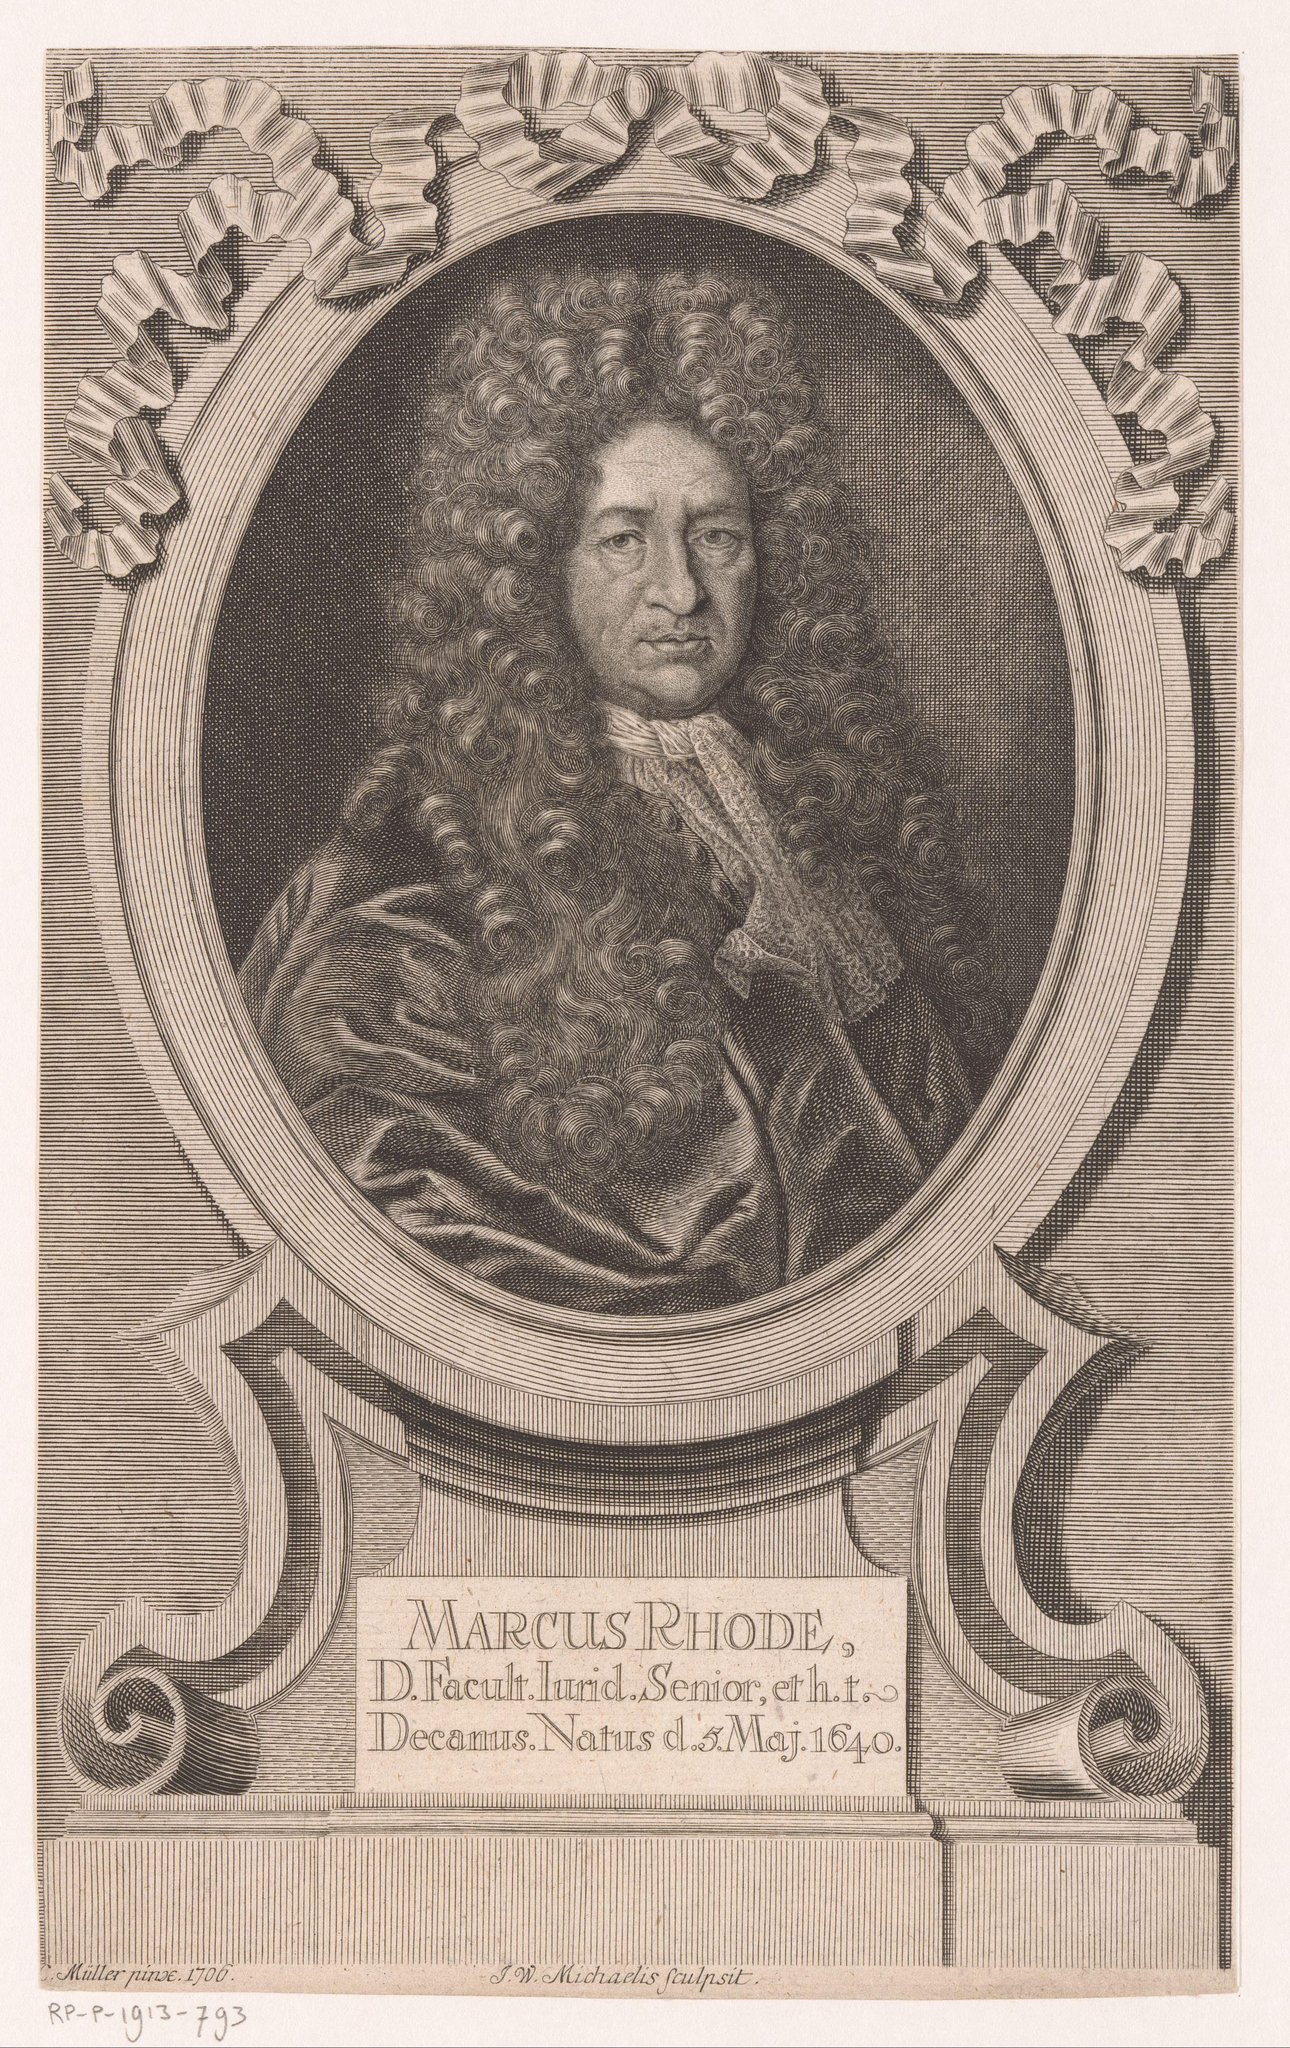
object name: print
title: Portret van Marcus Rhode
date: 1707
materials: paper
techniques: engraving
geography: germany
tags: historical persons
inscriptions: collector's mark: Lugt 2228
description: Prent gebruikt voor de publicatie: Beckmann, Johann Christoph. Notitia Universitatis Francofurtanae (...). Frankfurt an der Oder: erven Jeremias Schrey en Johann Christoph Hartmann, 1707.